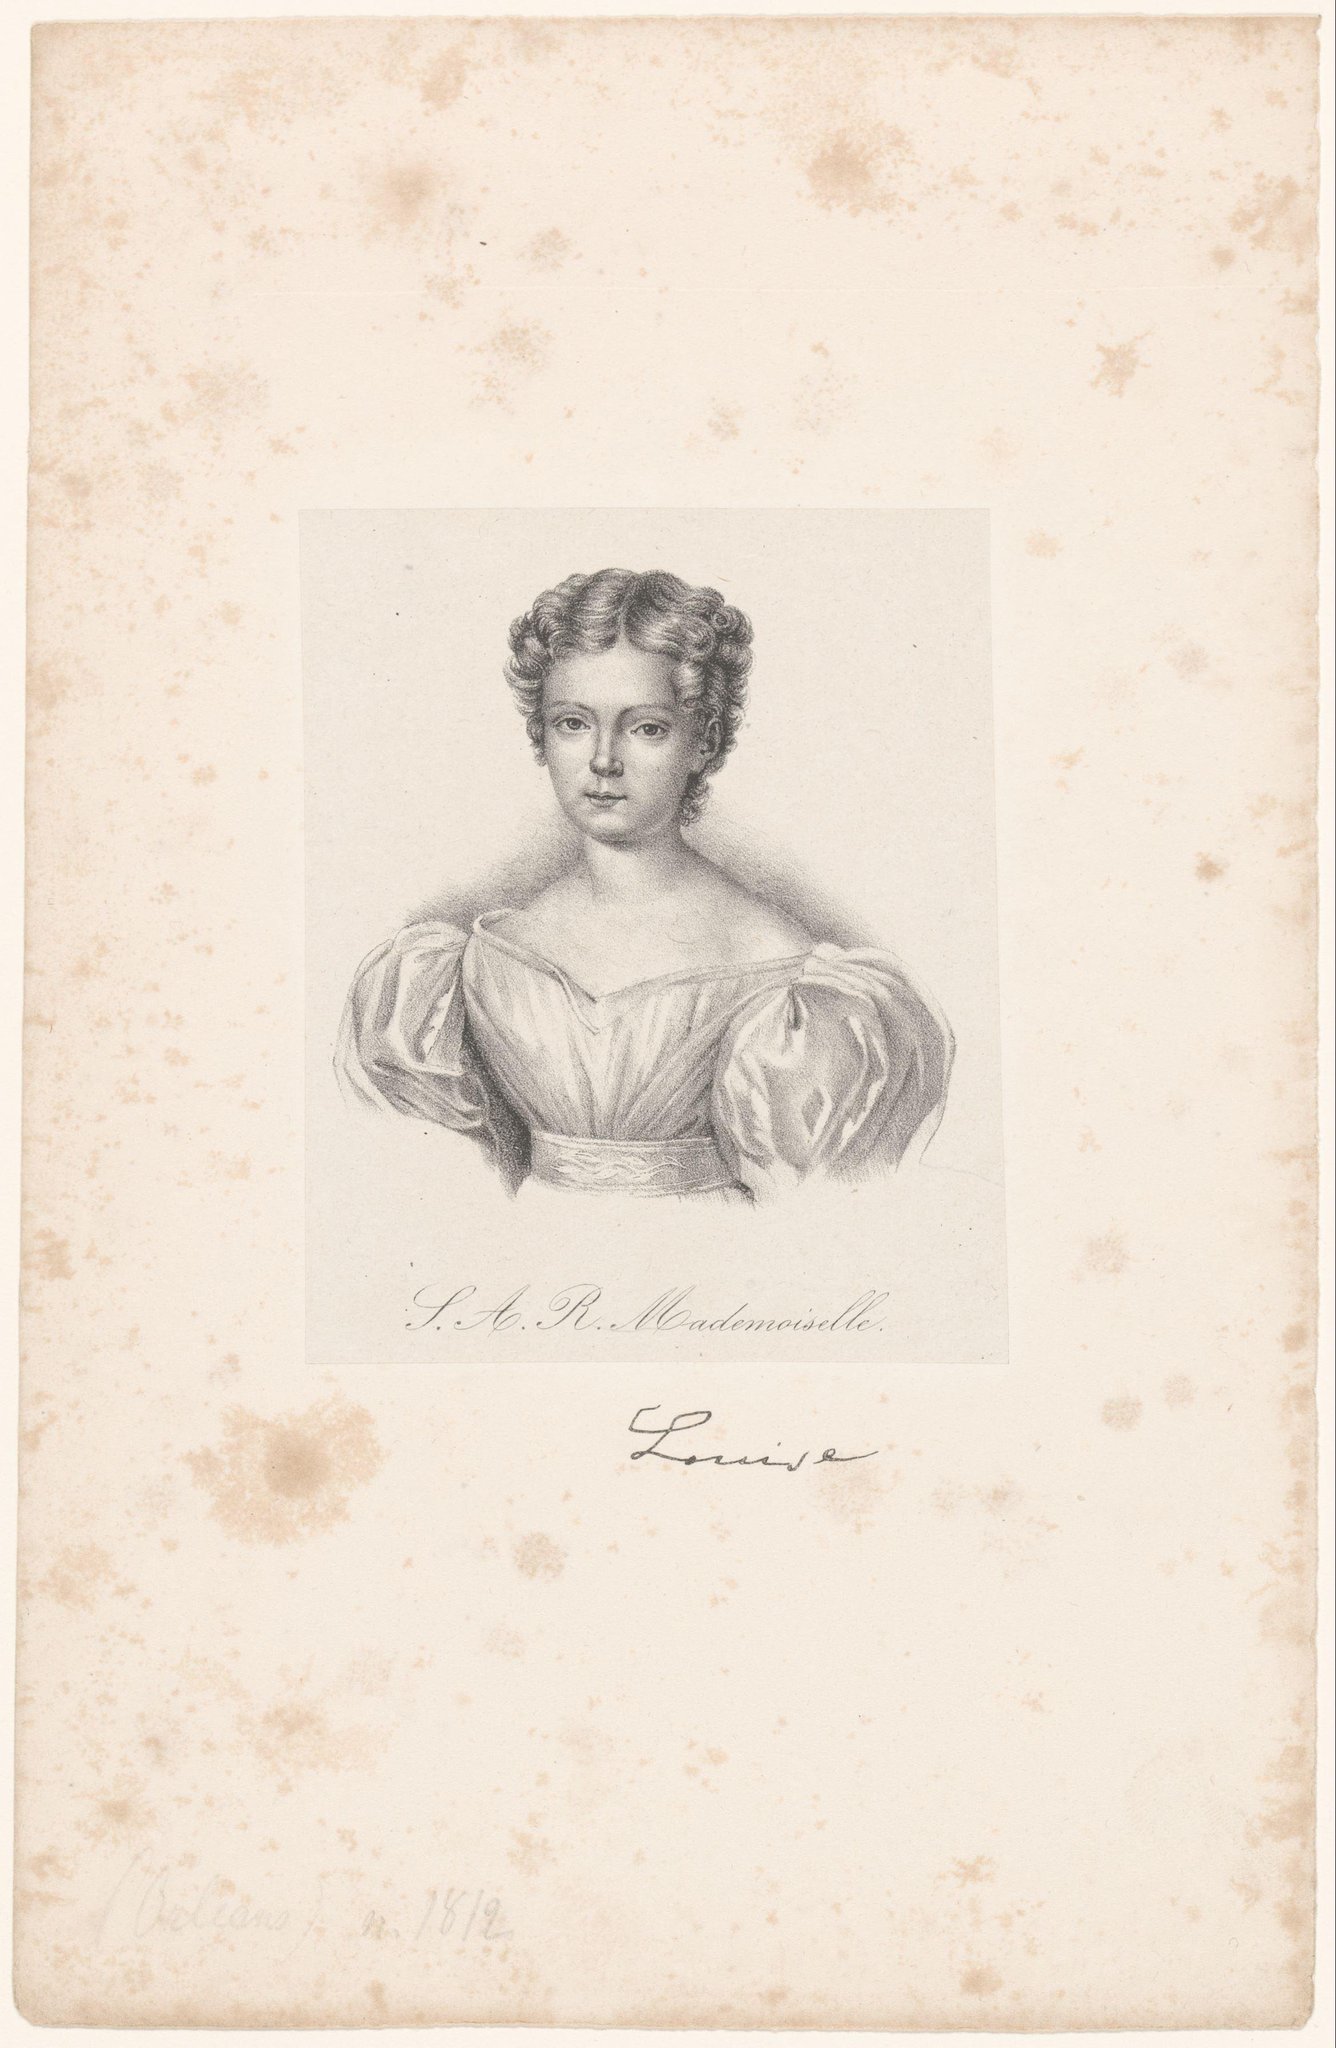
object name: print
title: Portret van Louise Maria van Frankrijk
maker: Anonymous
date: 1830-1842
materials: paper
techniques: lithograph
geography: paris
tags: paris, venice, historical persons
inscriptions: collector's mark: Lugt 2228a